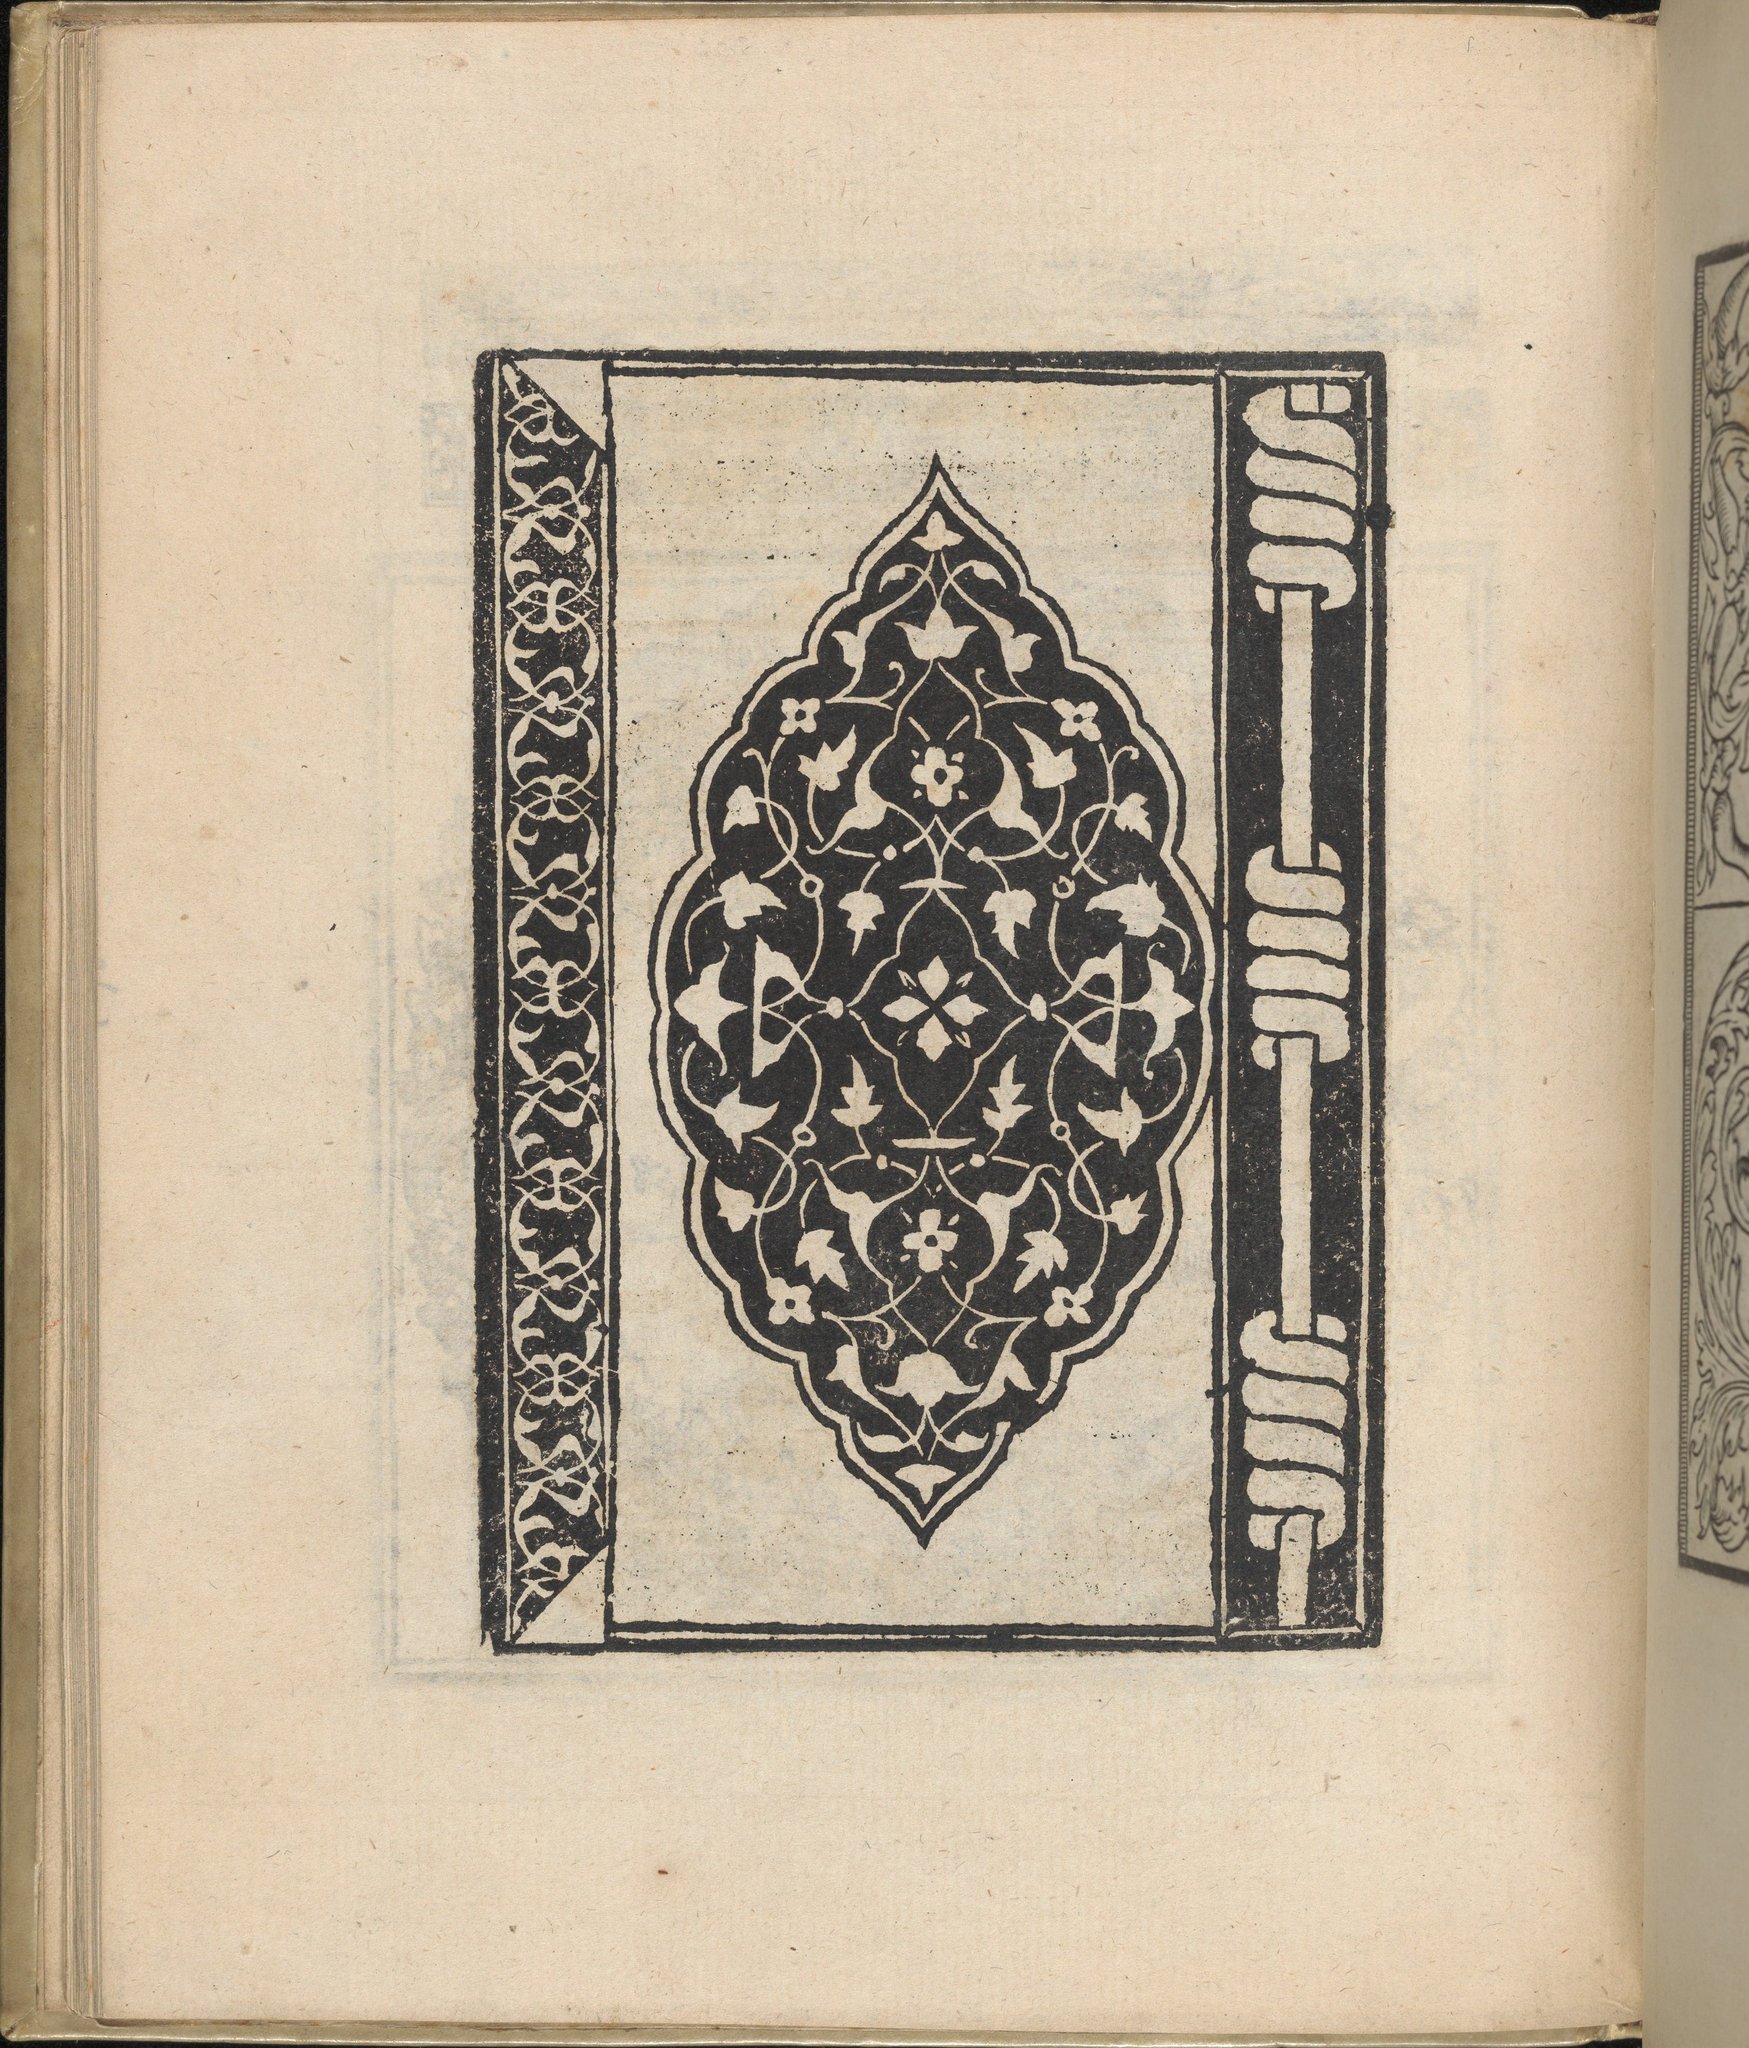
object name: book print ornament architecture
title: Trionfo Di Virtu. Libro Novo..., page 22 (recto)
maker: matteo pagano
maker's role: publisher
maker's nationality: italian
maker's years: 1515-1588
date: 1563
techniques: woodcut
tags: flowers